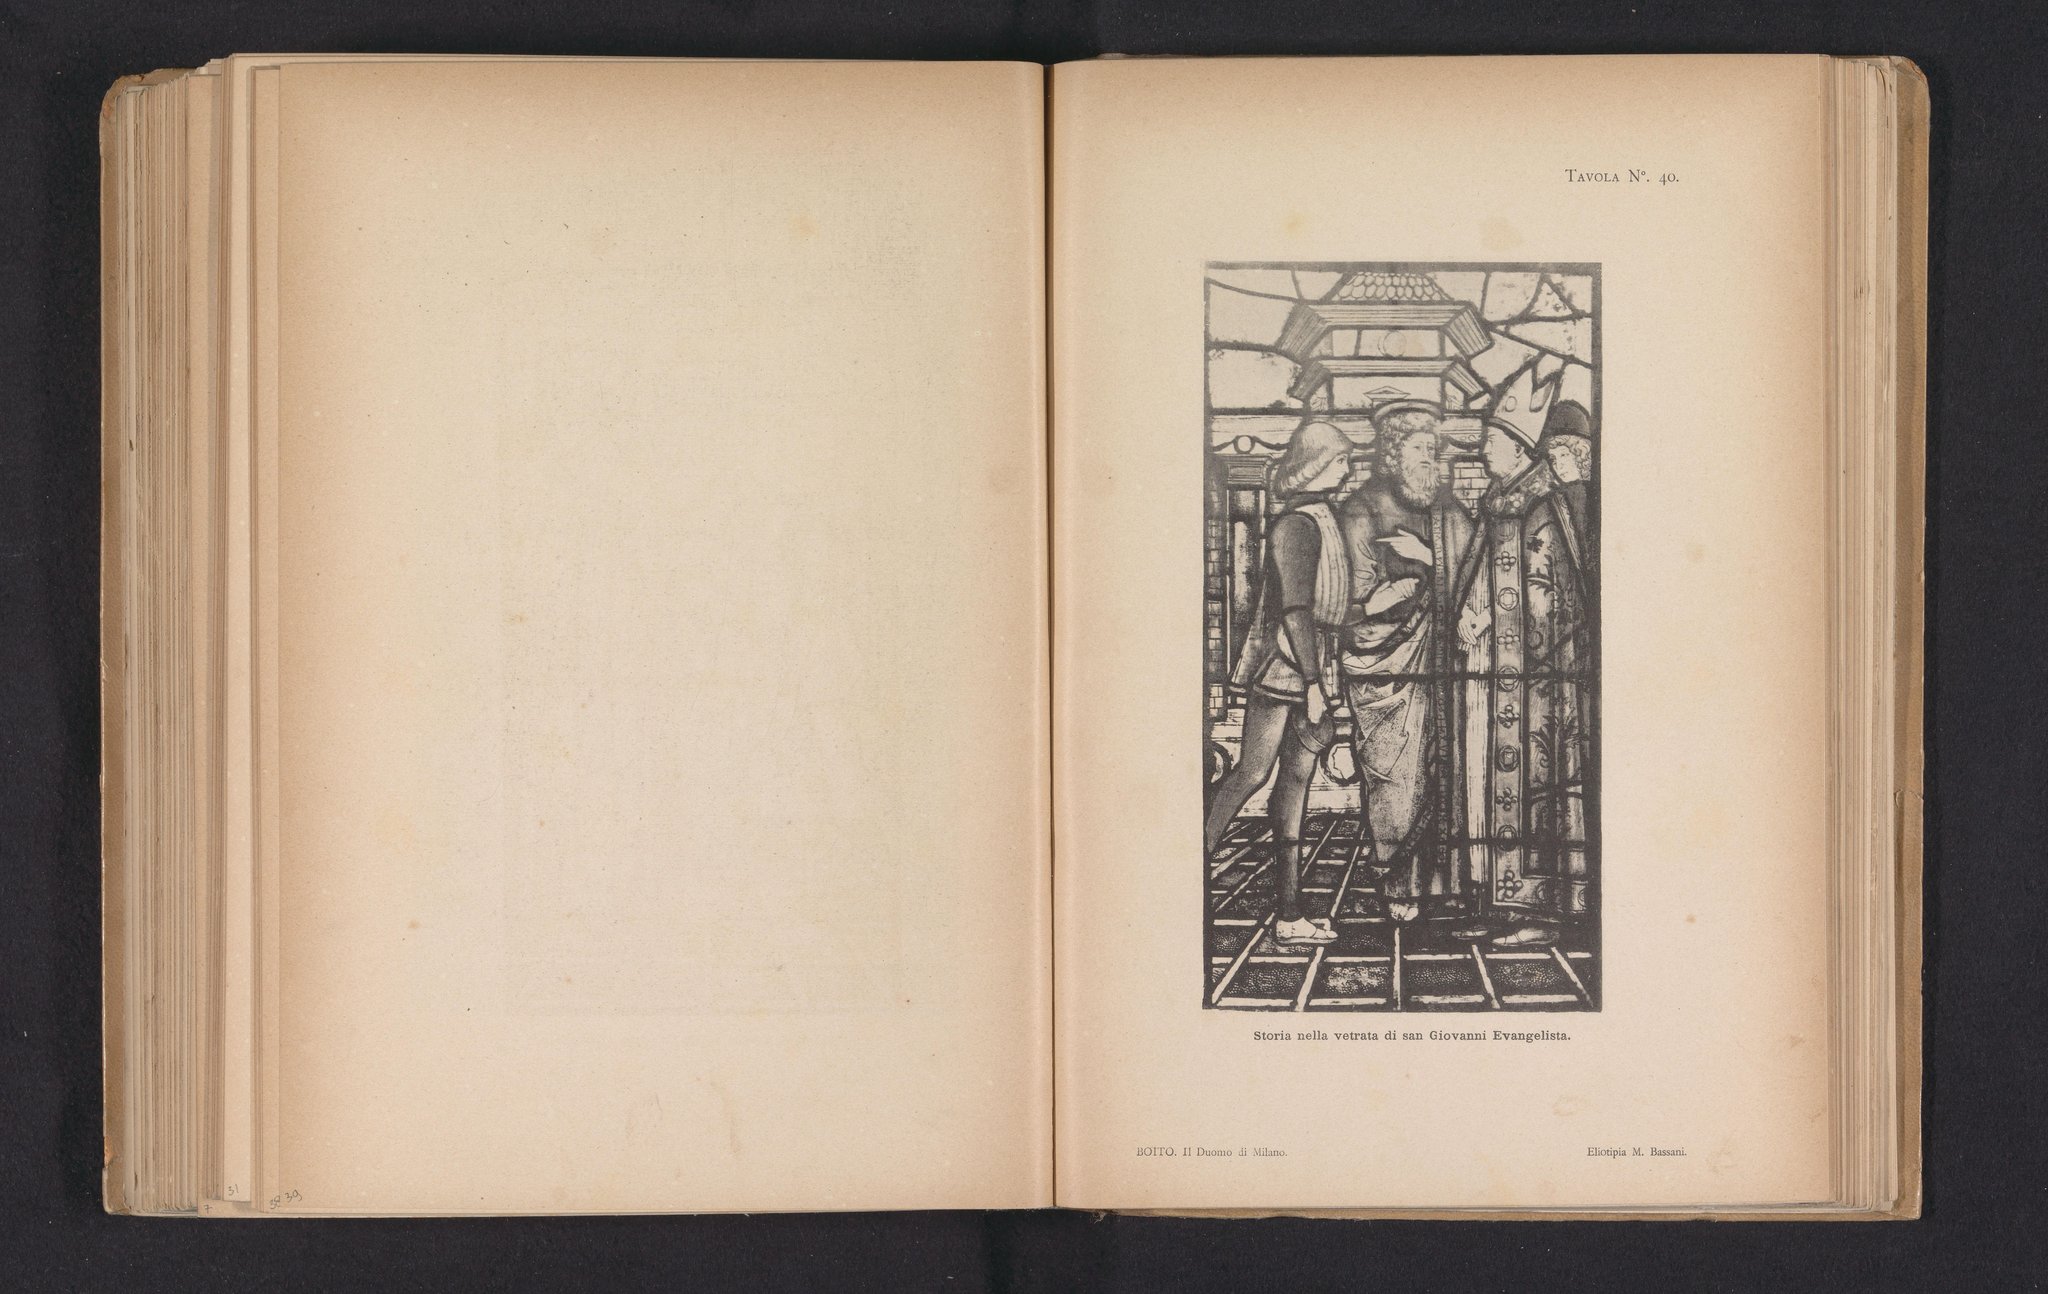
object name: page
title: Storia nella vetrata di san Giovanni Evangelista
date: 1879-1889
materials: paper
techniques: photograph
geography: milan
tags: church-window, e.g. rose-window, epistles of john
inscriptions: number: ‘Tavola No. 40.’